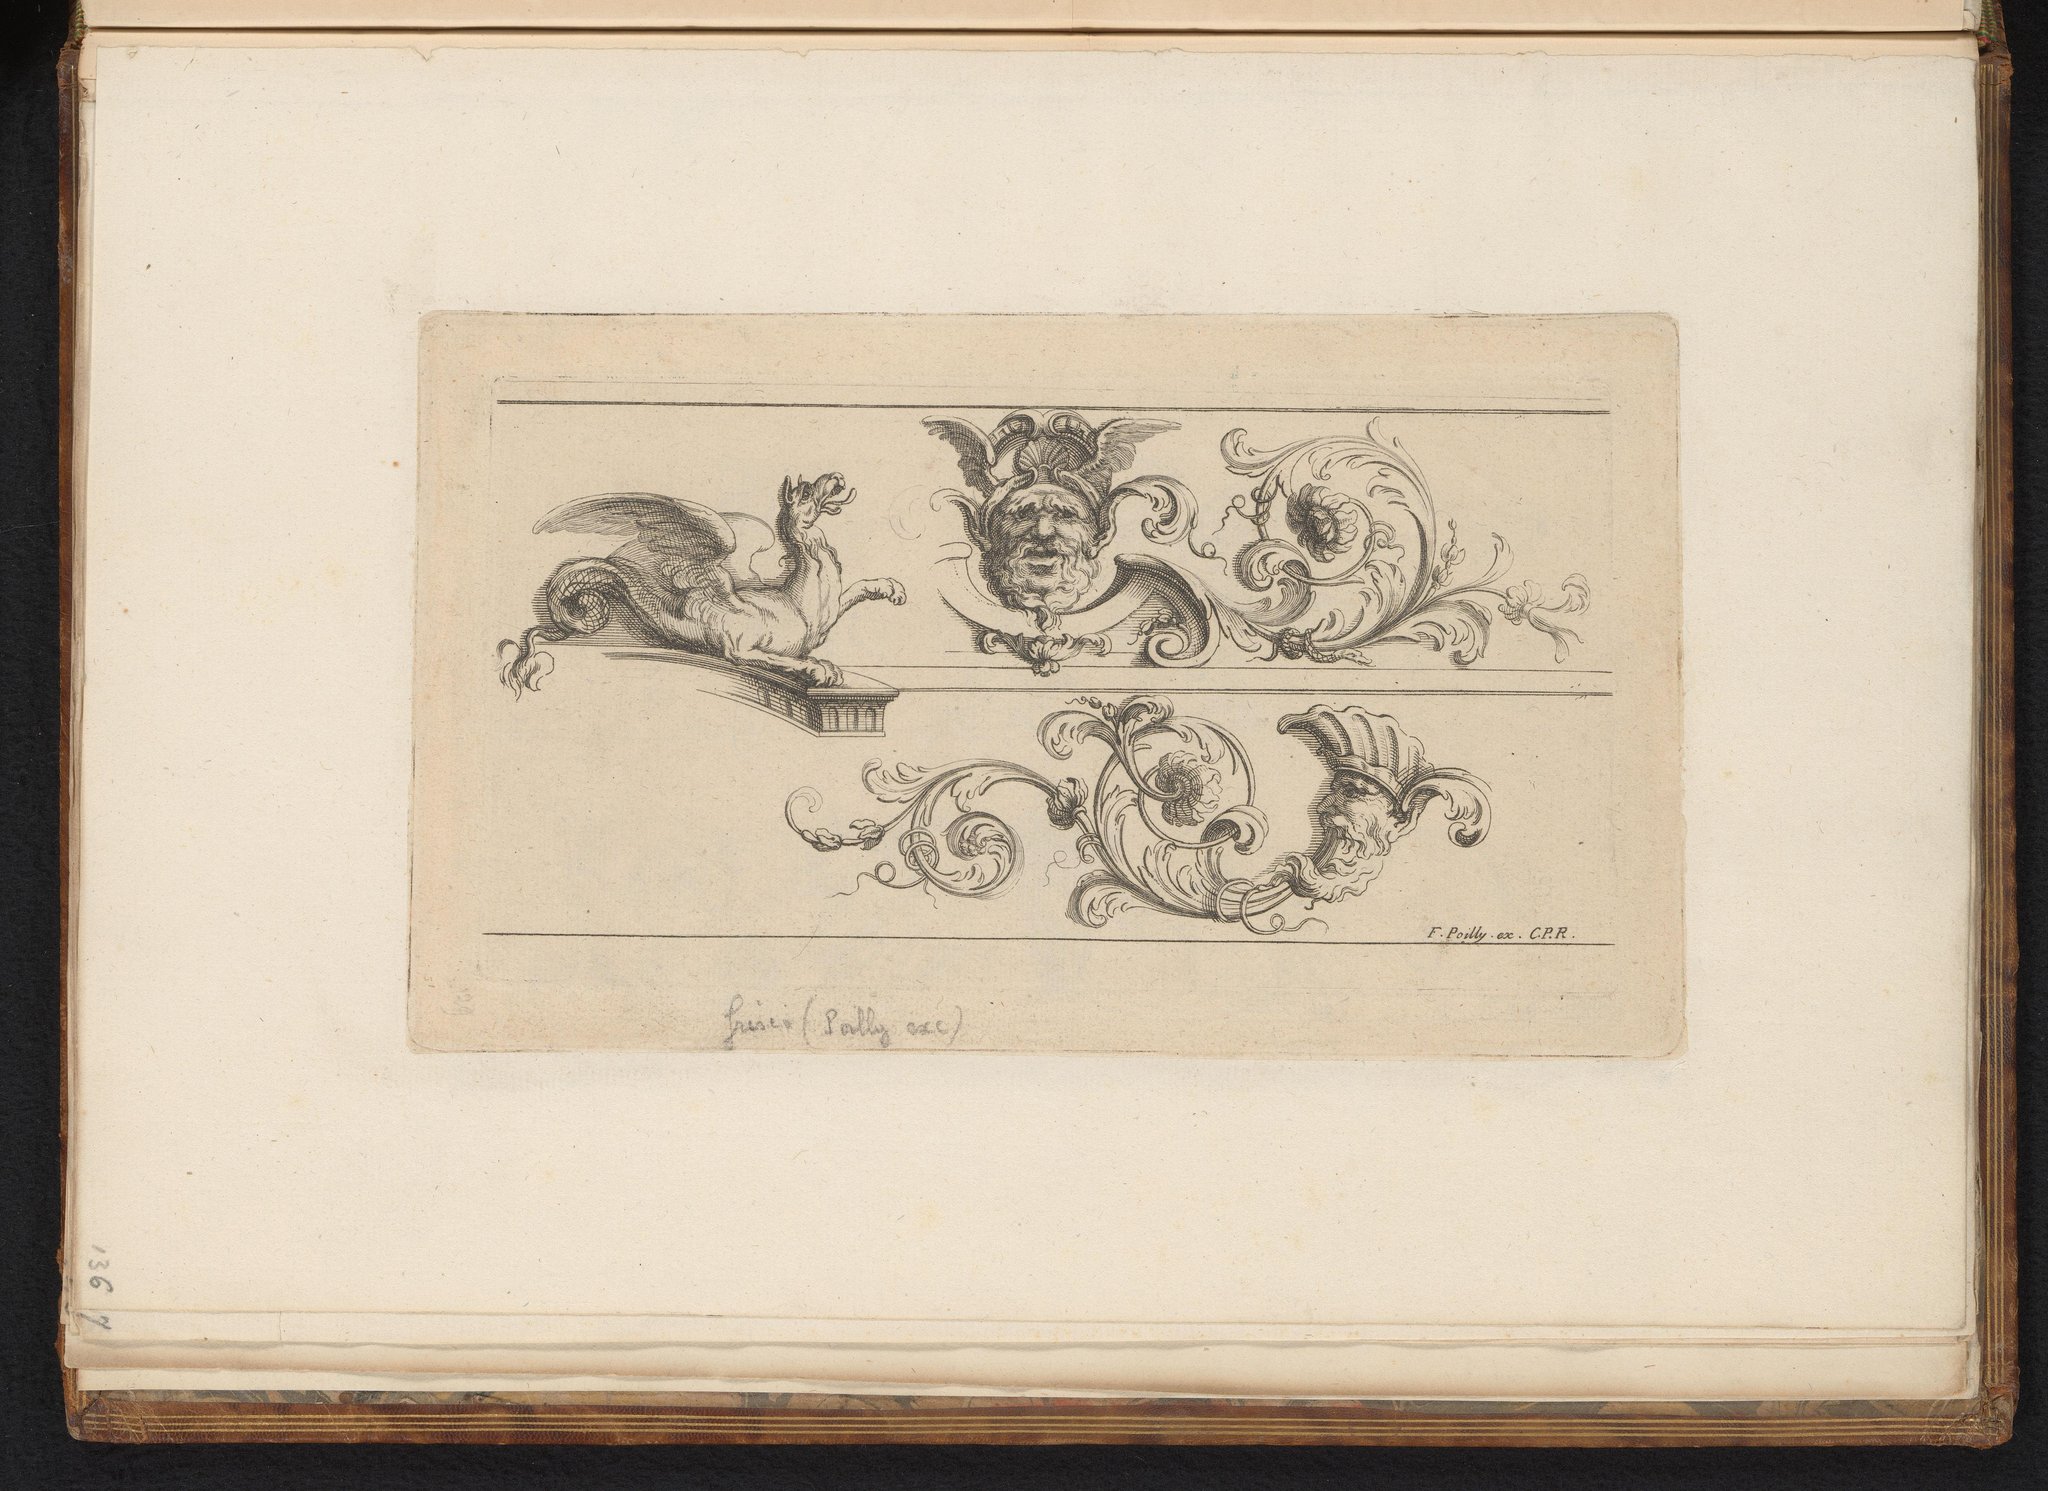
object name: ornament print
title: Fries met arabesken en zeewezen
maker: Anonymous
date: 1682-1723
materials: paper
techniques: etching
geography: france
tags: ornament ~ arabesque, monsters of the sea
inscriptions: collector's mark: Lugt 2228, collector's mark: Lugt 2760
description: Prent maakt deel uit van een serie van zes prenten.